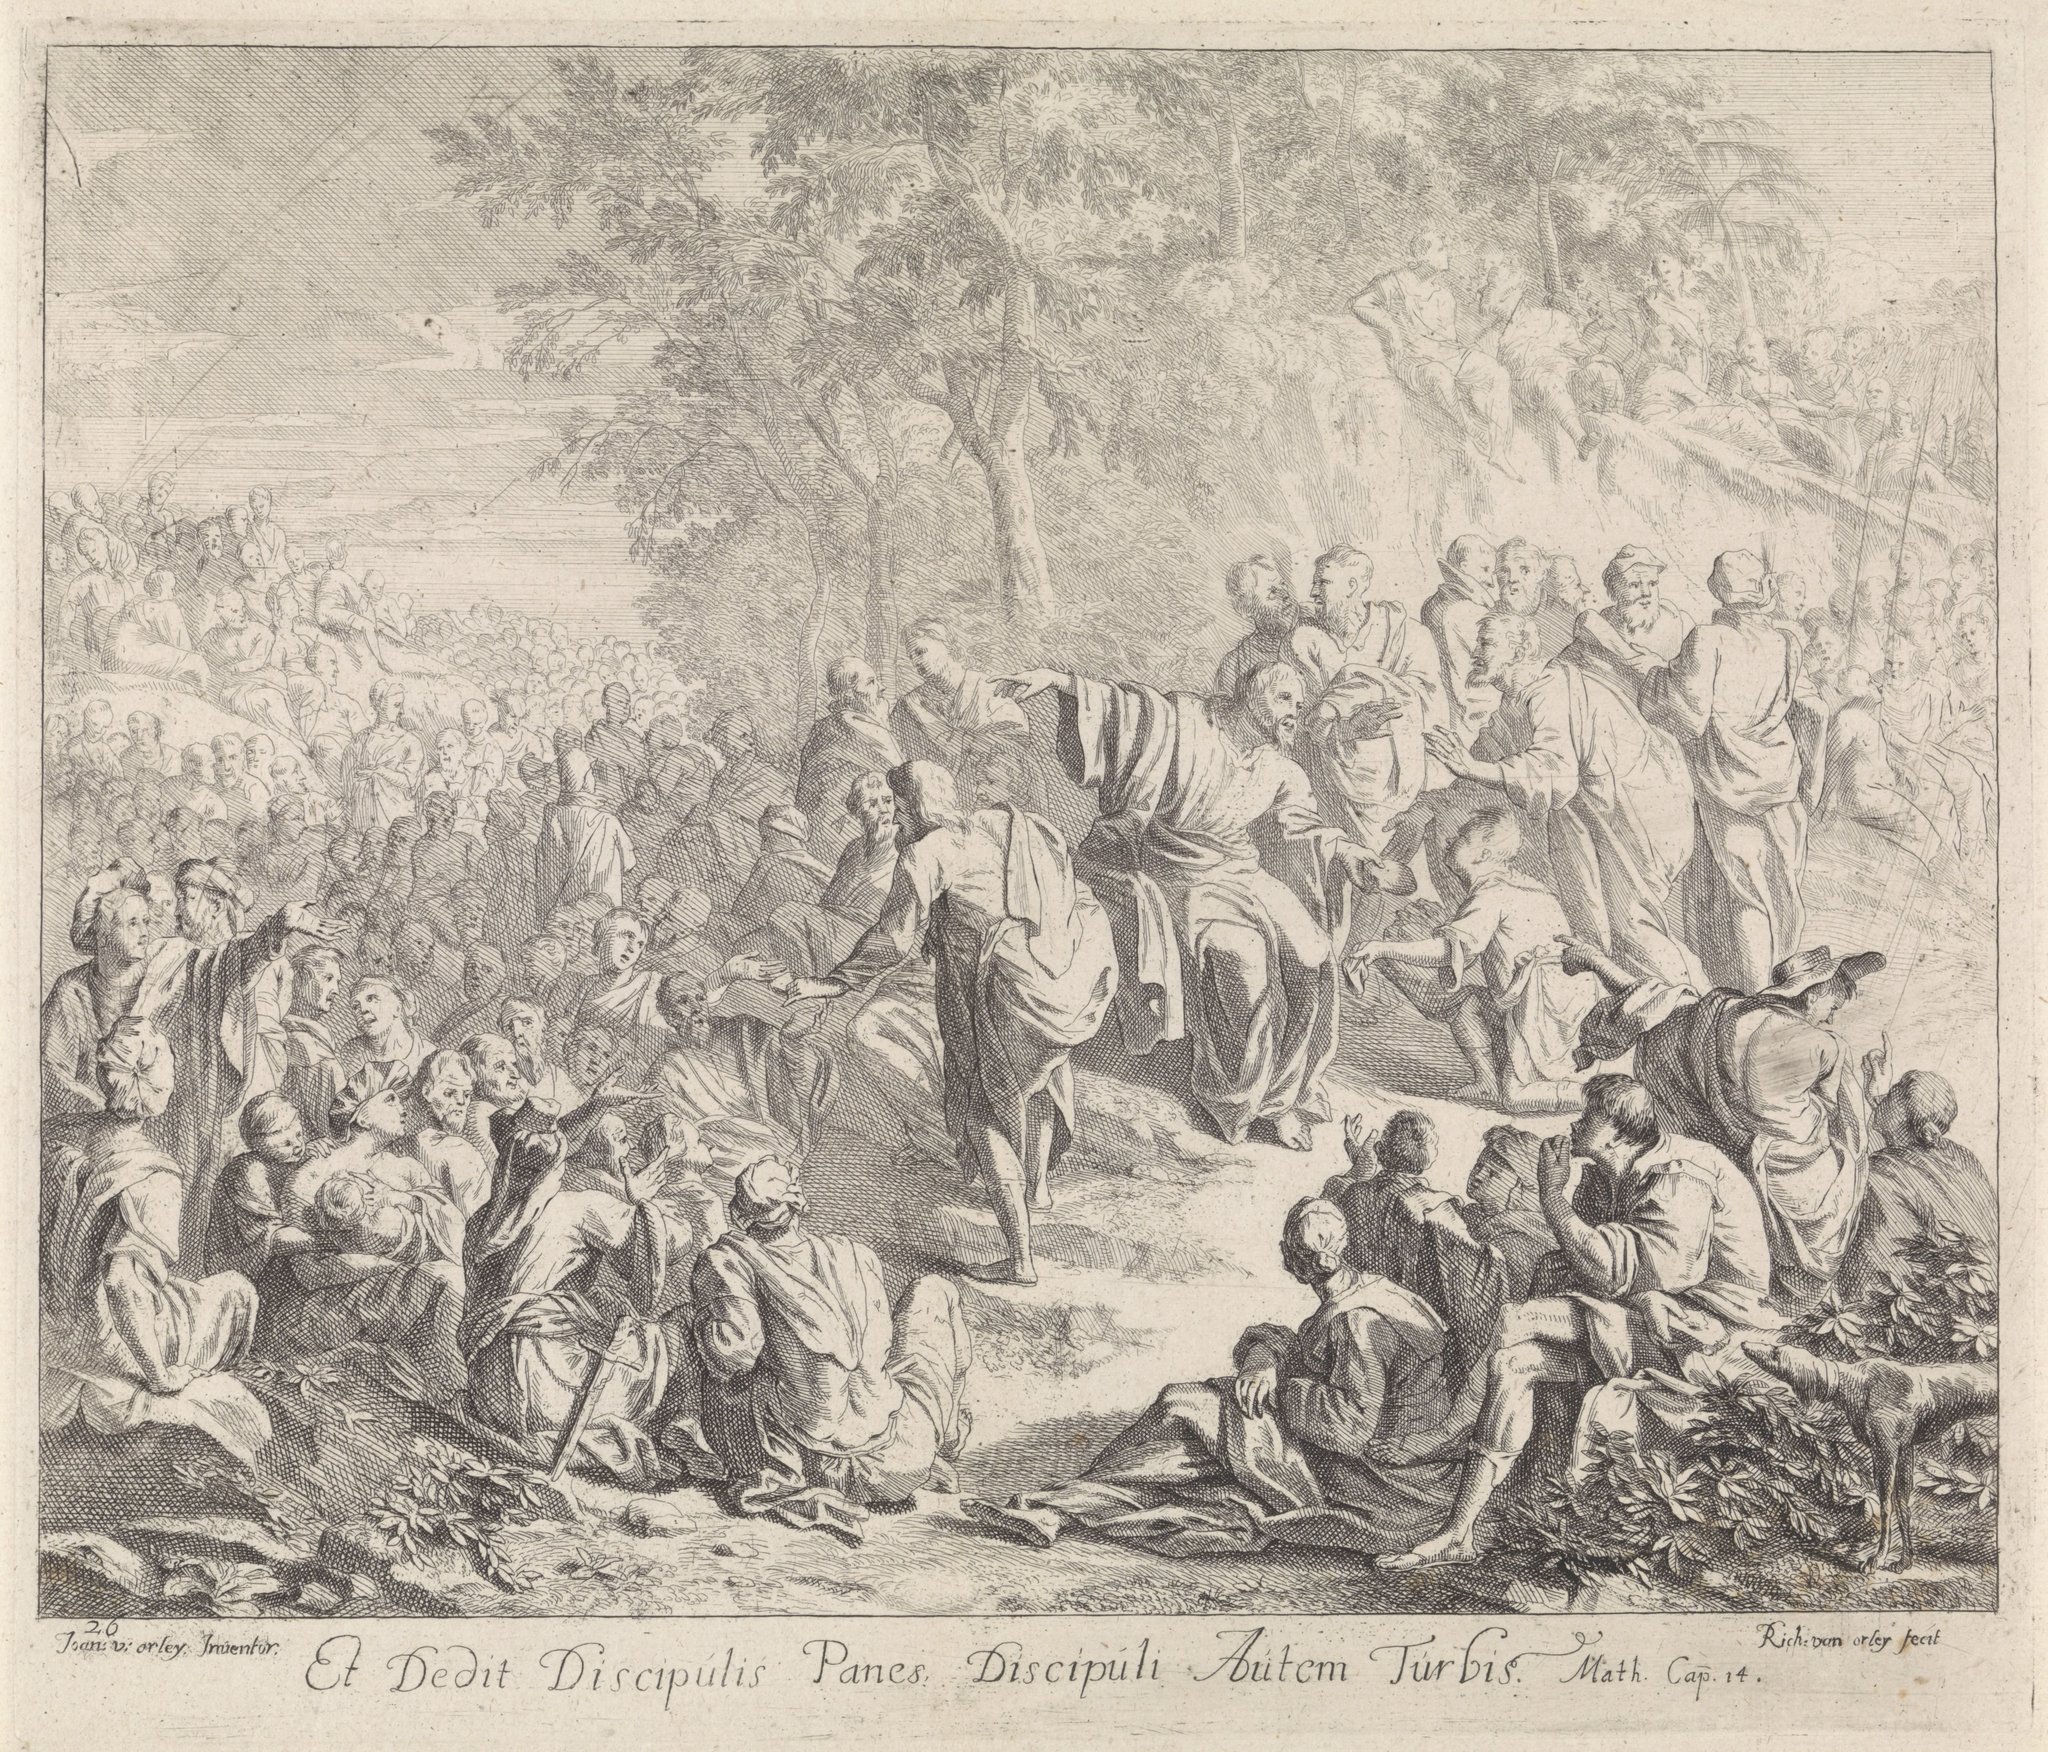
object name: print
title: Scènes uit het Nieuwe Testament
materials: paper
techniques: engraving, etching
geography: brussels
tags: multiplication of loaves and fishes for a multitude of four or five thousand people (matthew 14:13-21, 15:32-39; mark 6:32-44, 8:1-10; luke 9:10-17; john 6:1-14)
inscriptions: collector's mark: Lugt 240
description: In een dal zit een grote groep volgelingen van Christus te wachten. Christus zit rechts op een heuvel en krijgt van een jongetje één mand met broden en vissen. Hij laat het voedsel door zijn discipelen uitdelen. Onder de afbeelding een Latijns vers uit Math. 14.